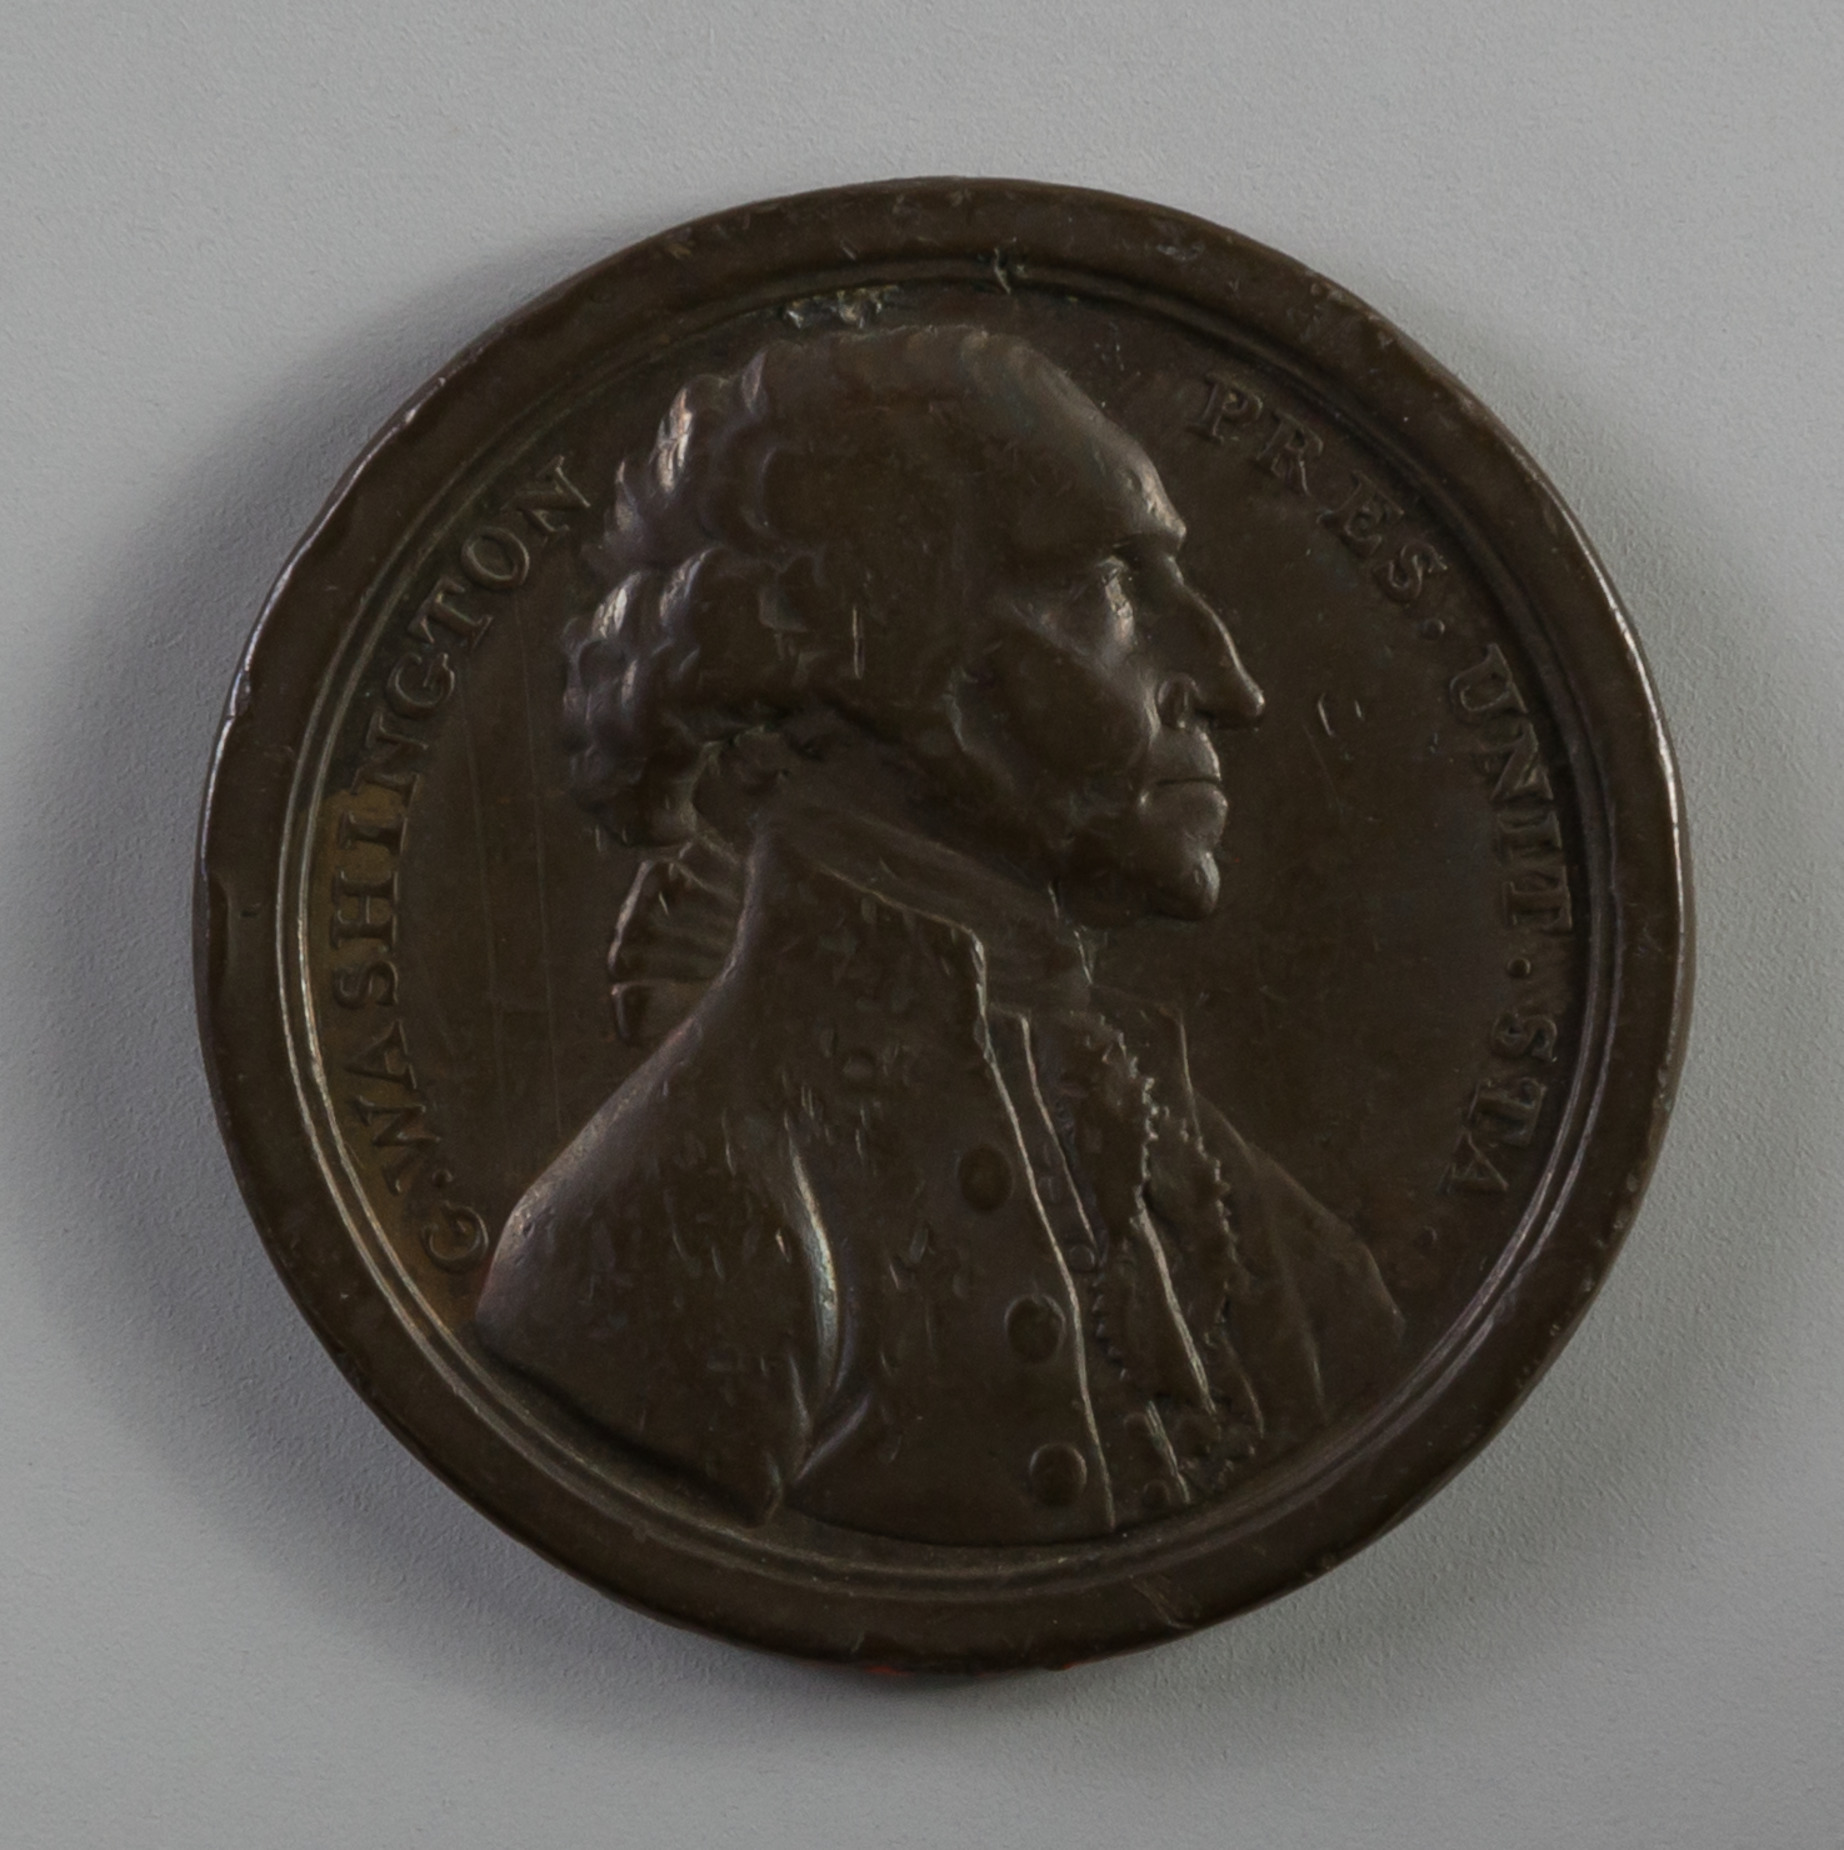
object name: medal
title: Washington's Resignation of the Presidency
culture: american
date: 1797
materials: bronze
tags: george washington,profiles